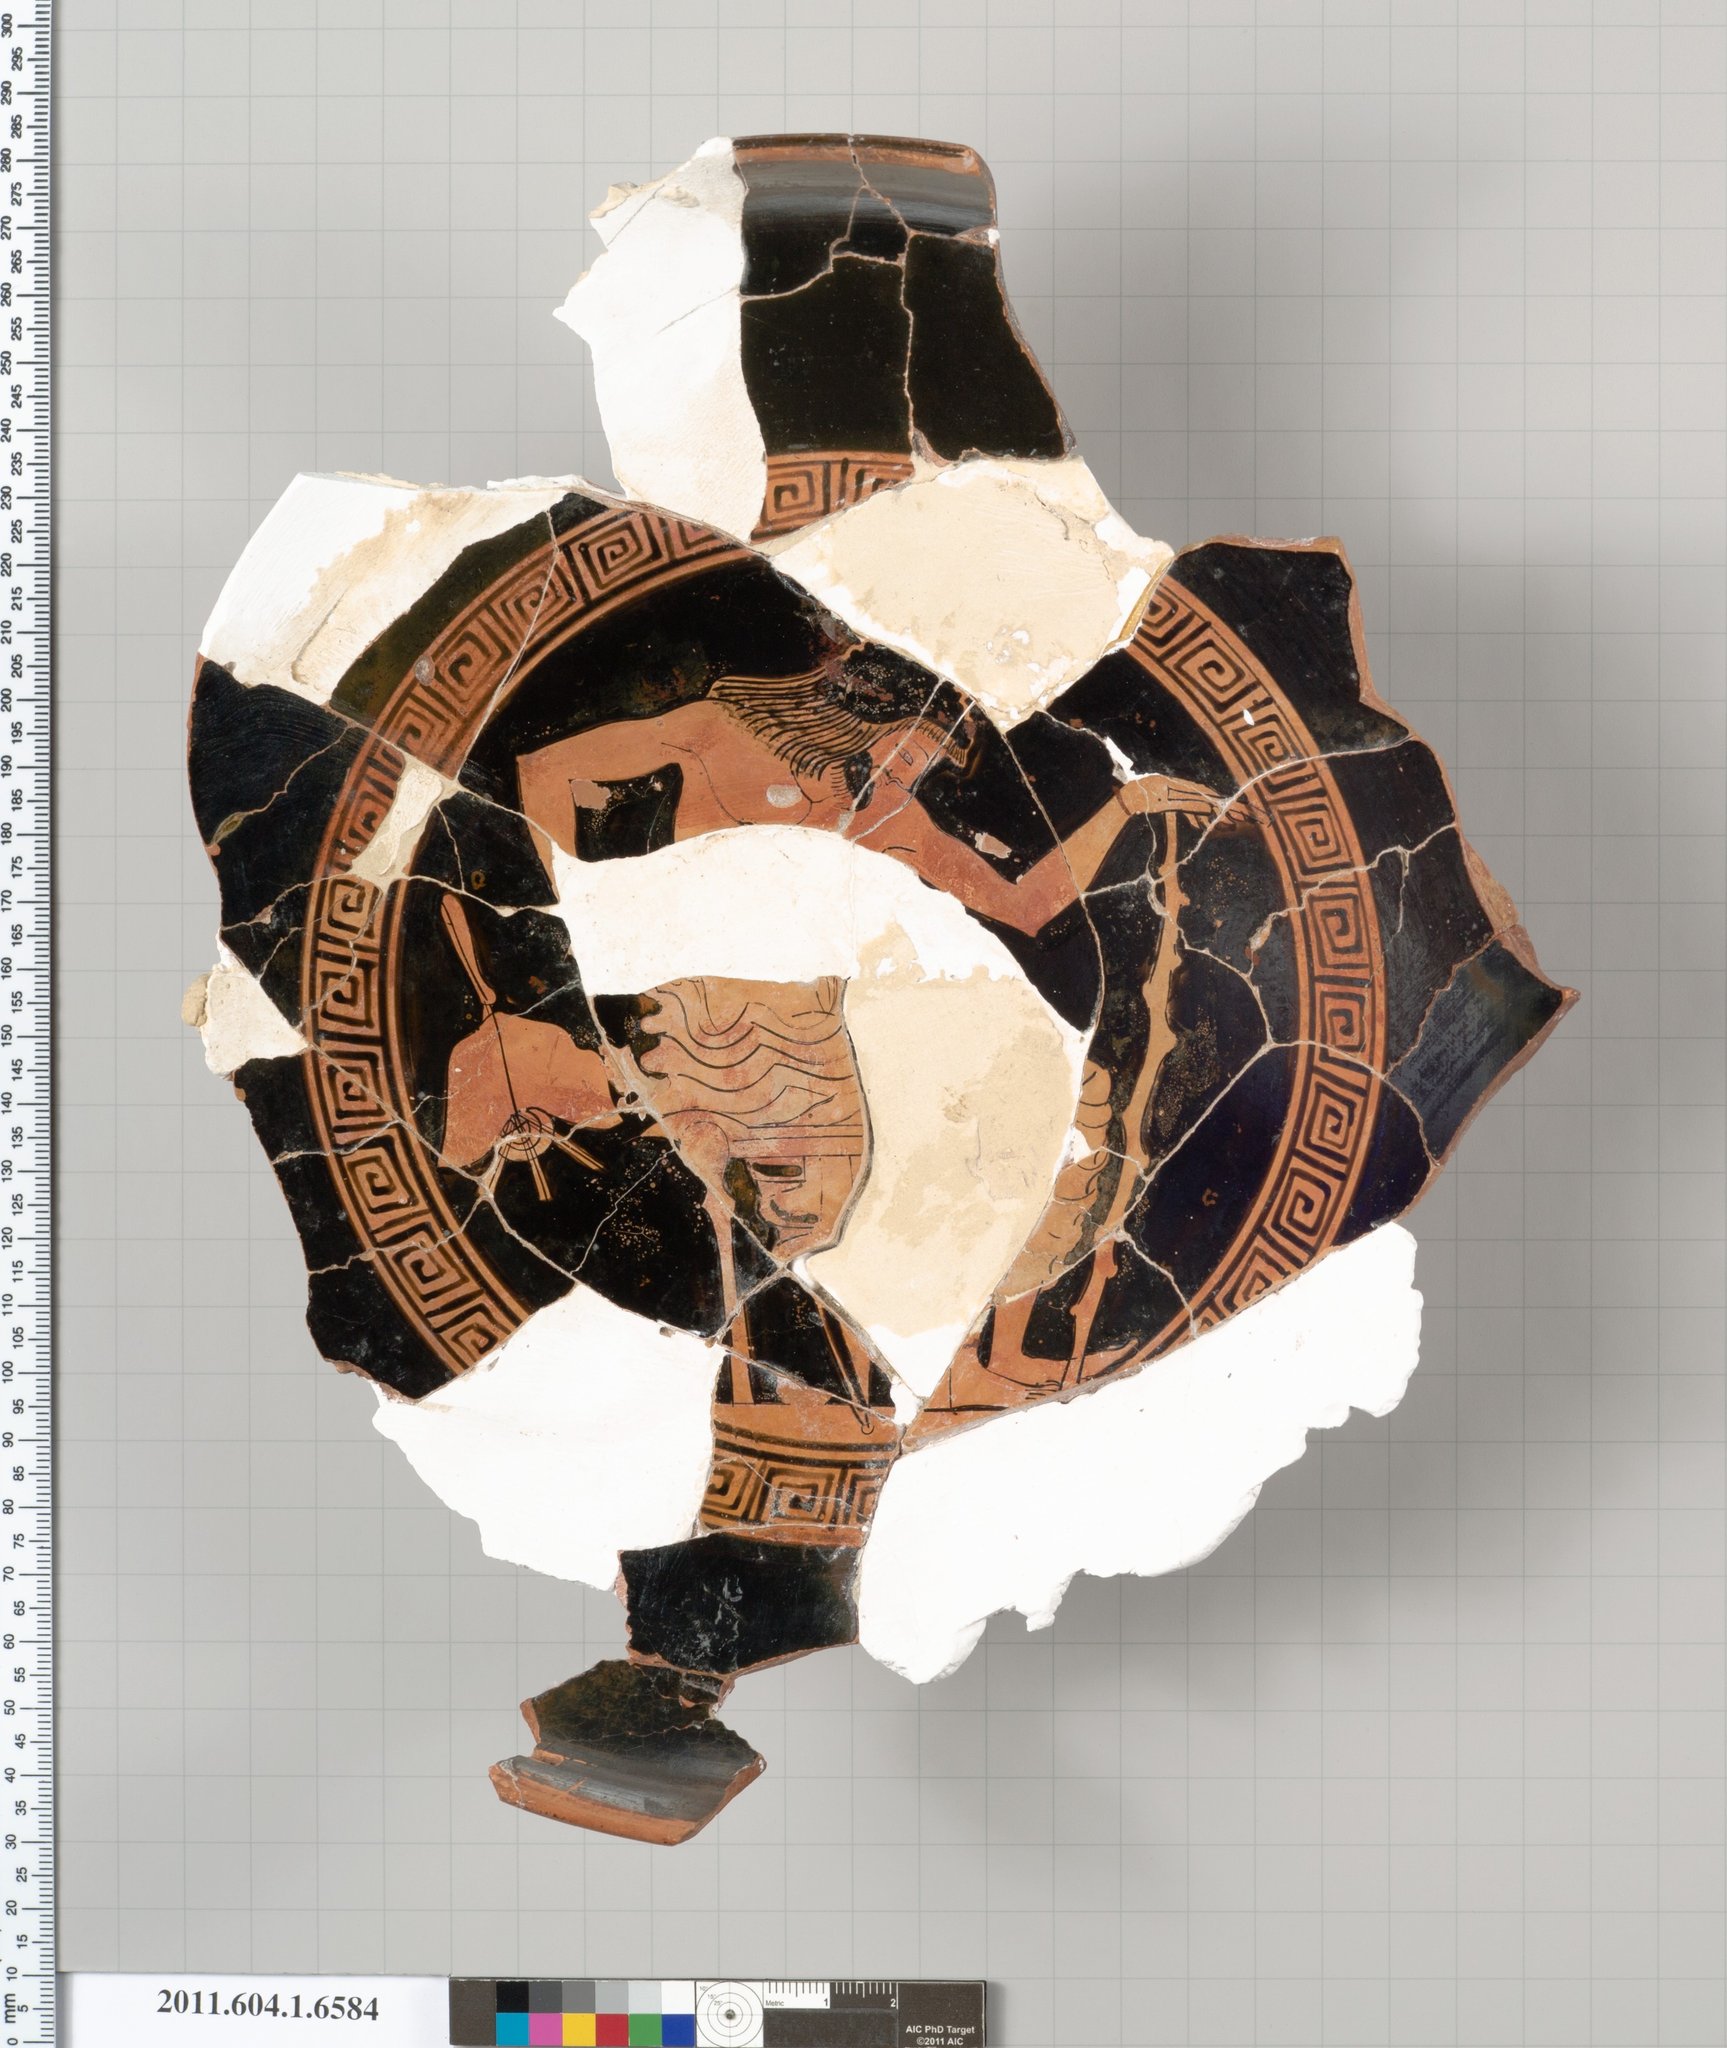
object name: kylix fragment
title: Terracotta fragment of a kylix (drinking cup)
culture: greek, attic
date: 490-480 BCE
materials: terracotta